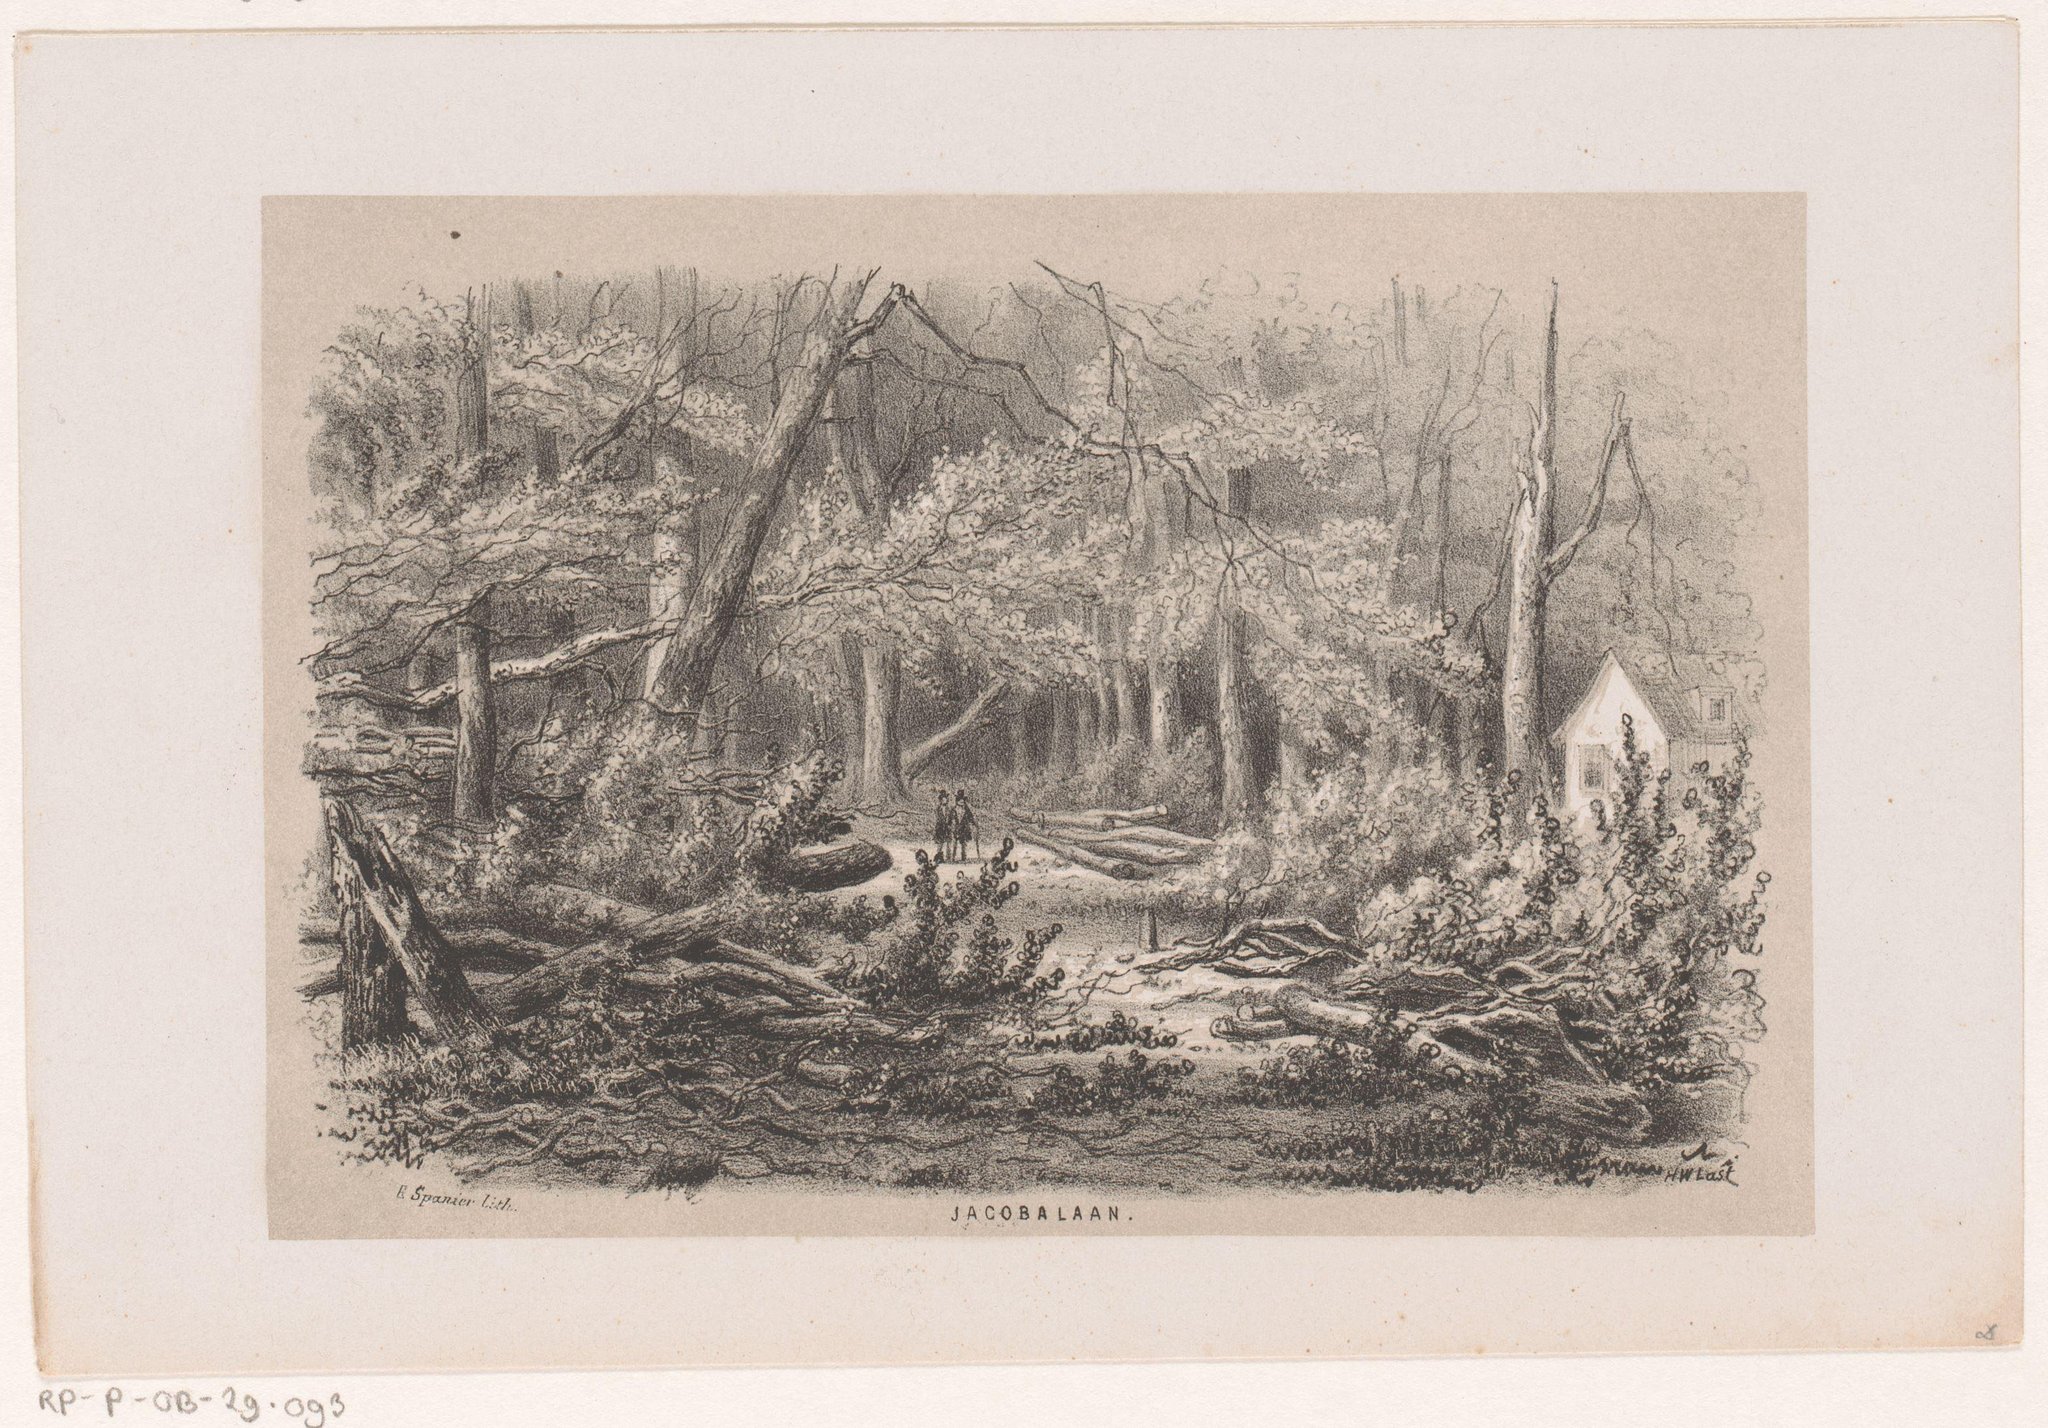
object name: print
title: Omgewaaide bomen aan de Jacobalaan, na de storm van 28 mei 1860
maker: m.m. couvée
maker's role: publisher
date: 1860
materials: paper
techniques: tone lithography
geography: the hague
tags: storm on land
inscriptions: collector's mark: Lugt 2228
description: Omgewaaide bomen aan de Jacobalaan, na de storm. Onderdeel van het album met tien losse steendrukken met voorstellingen van de schade aangericht door de 'Pinksterstorm' van 28 mei 1860 in het Haagse Bos en omgeving.